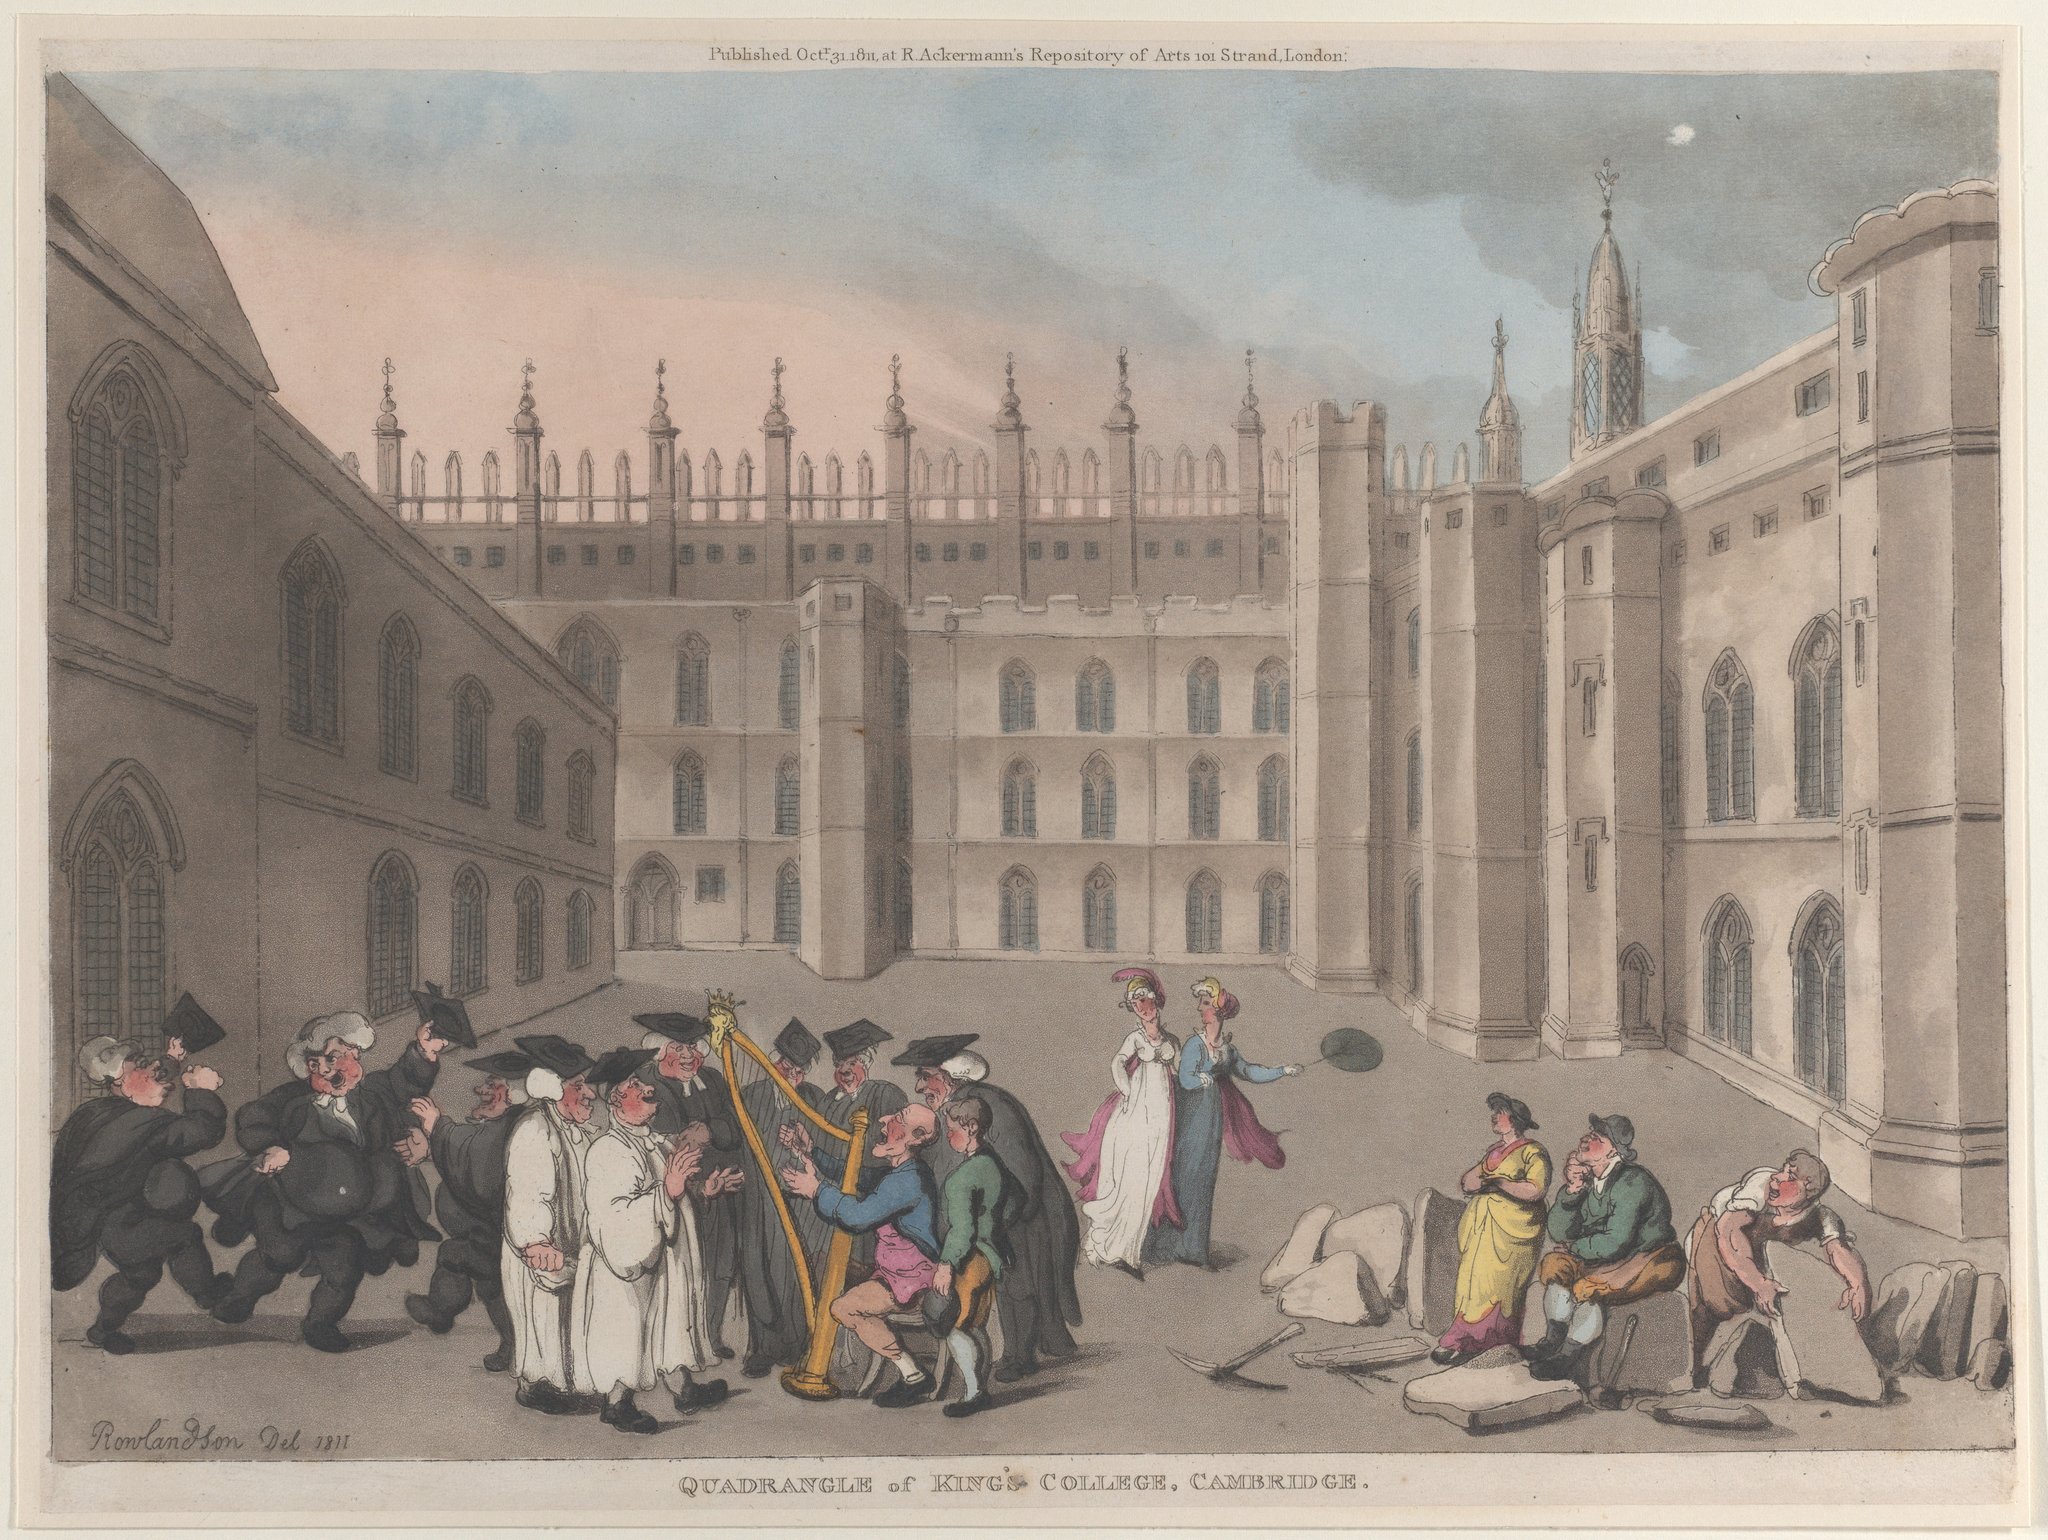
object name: print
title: Quadrangle of King's College, Cambridge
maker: thomas rowlandson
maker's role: artist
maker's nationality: british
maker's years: 1757-1827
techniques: aquatint, etching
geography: london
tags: satire,men,women,harps,musicians